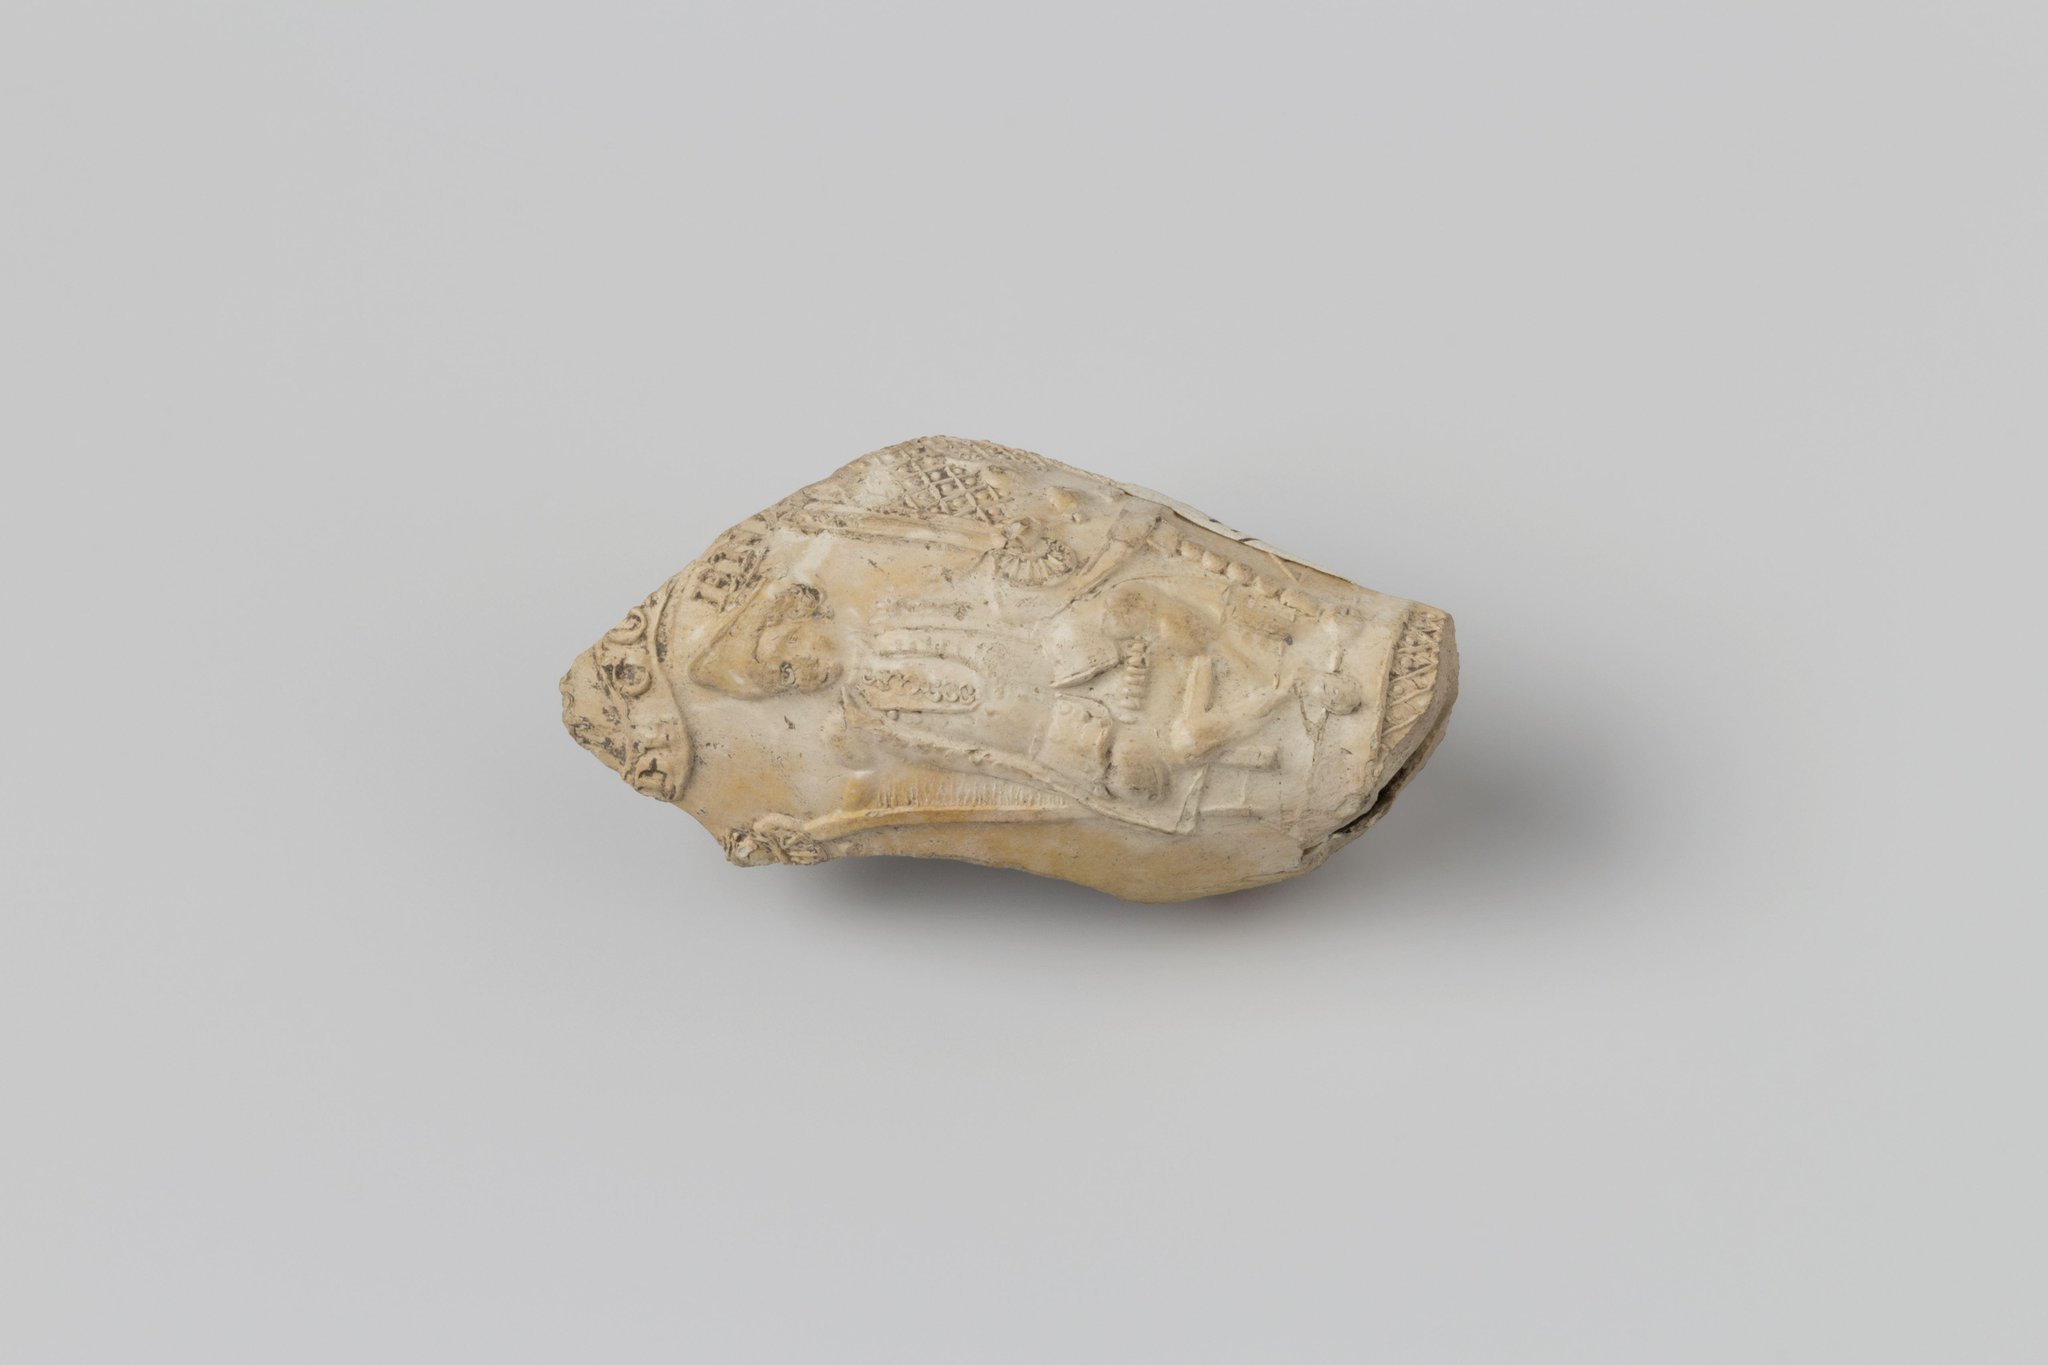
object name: pipe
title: Fragment pijpenkop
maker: Anonymous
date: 1740-1780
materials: clay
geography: gouda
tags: rotterdam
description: Fragment pijpenkop met een zittend figuur afgebeeld. Van de opgravingen op de Hofstede Arentsburg 1827-1831 onder toezicht van Professor Reuvens.